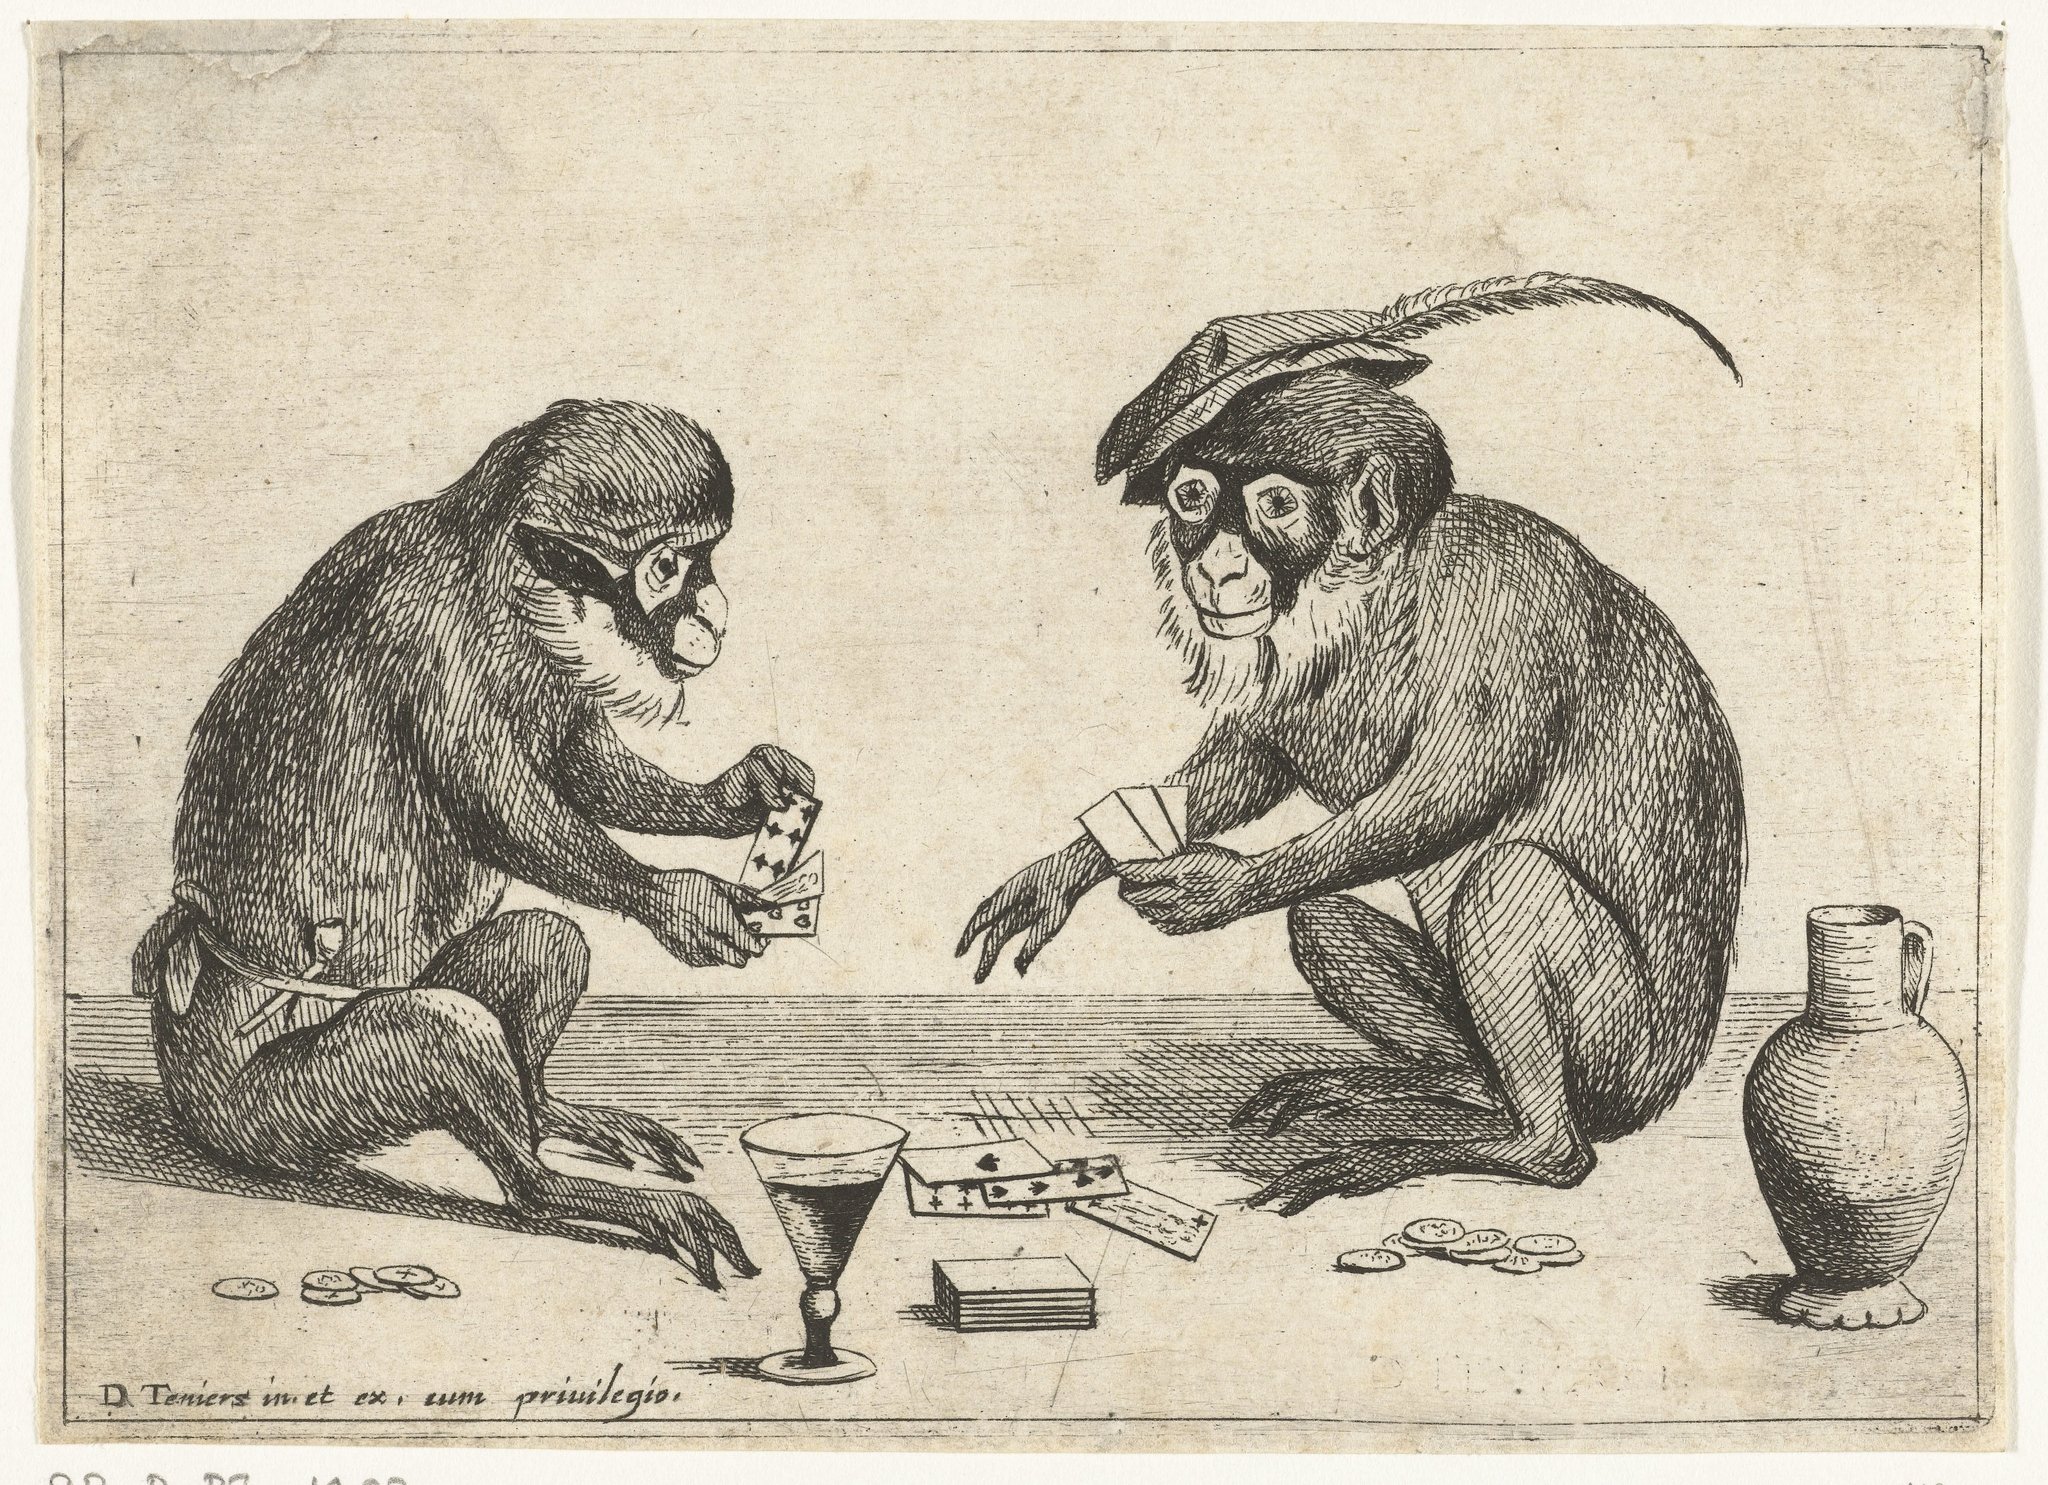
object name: print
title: Verschillende bedrijven uit het menselijke leven door apen voorgesteld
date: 1635-1690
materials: paper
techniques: etching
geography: southern netherlands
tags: animals acting as human beings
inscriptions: collector's mark: Lugt 240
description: Twee apen zitten op de grond en zijn aan het kaarten. De rechtse draagt een hoed met een hanenveer. Prent uit een serie van zes prenten en een titelprent waarin verschillende menselijke bezigheden door apen voorgesteld worden.